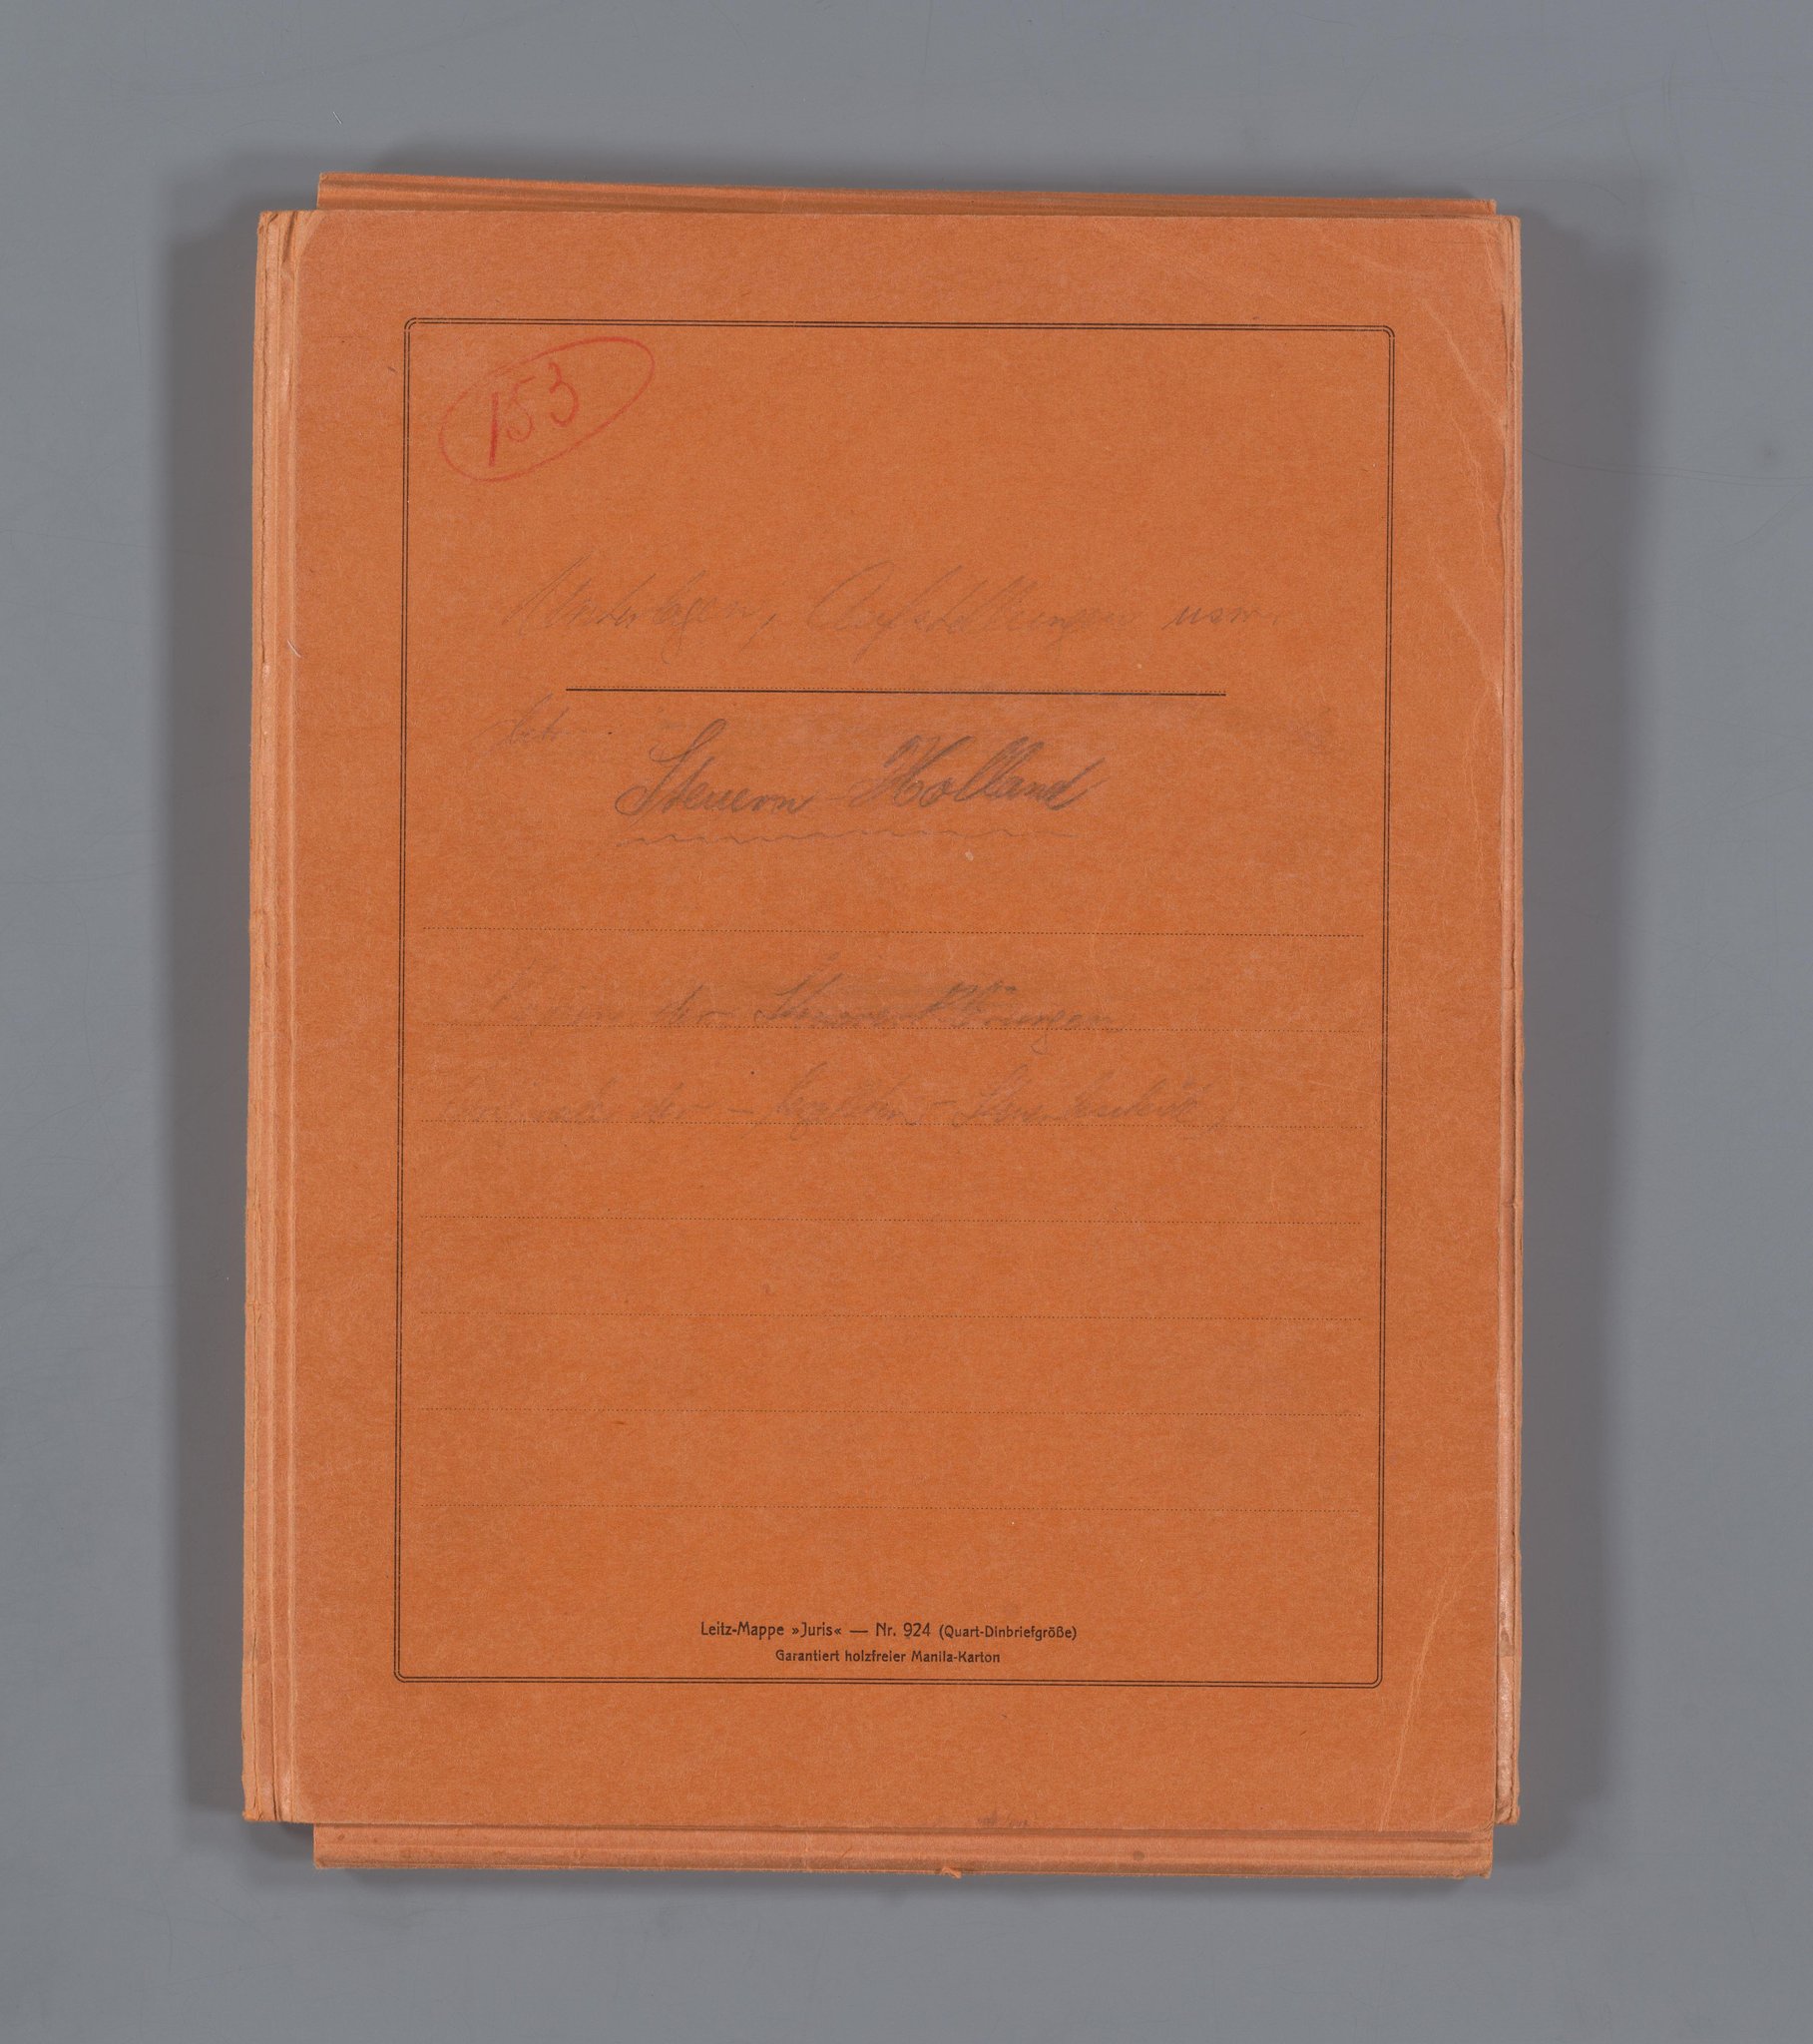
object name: document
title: Belastingaangiften van Eugen Wachenheimer over de periode 1937-1942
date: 1937-1942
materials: paper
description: Dit object is onderdeel van de nalatenschap van Isabel Elon-Wachenheimer (1928-2010). Tot haar overlijden behoorde het samen met de andere objecten uit de nalatenschap tot haar privédomein van Isabel Wachenheimer. In die particuliere context zijn deze objecten tezamen en individueel aandenkens - aan de jeugd, ouders en familie van Isabel Wachenheimer vóór en tijdens de Shoah en aan haar leven na de Tweede Wereldoorlog. Isabel Wachenheimer, die van juni 1943 tot mei 1945 gevangen zat in Kamp Westerbork, Theresienstadt, Auschwitz, Lenzing a/d Oberdonau (een buitenkamp van Mauthausen), overleefde de Shoah. Haar ouders – Eugène Wachenheimer en Else Wachenheimer-Moos - werden op 14 oktober 1944 in Auschwitz-Birkenau vermoord.